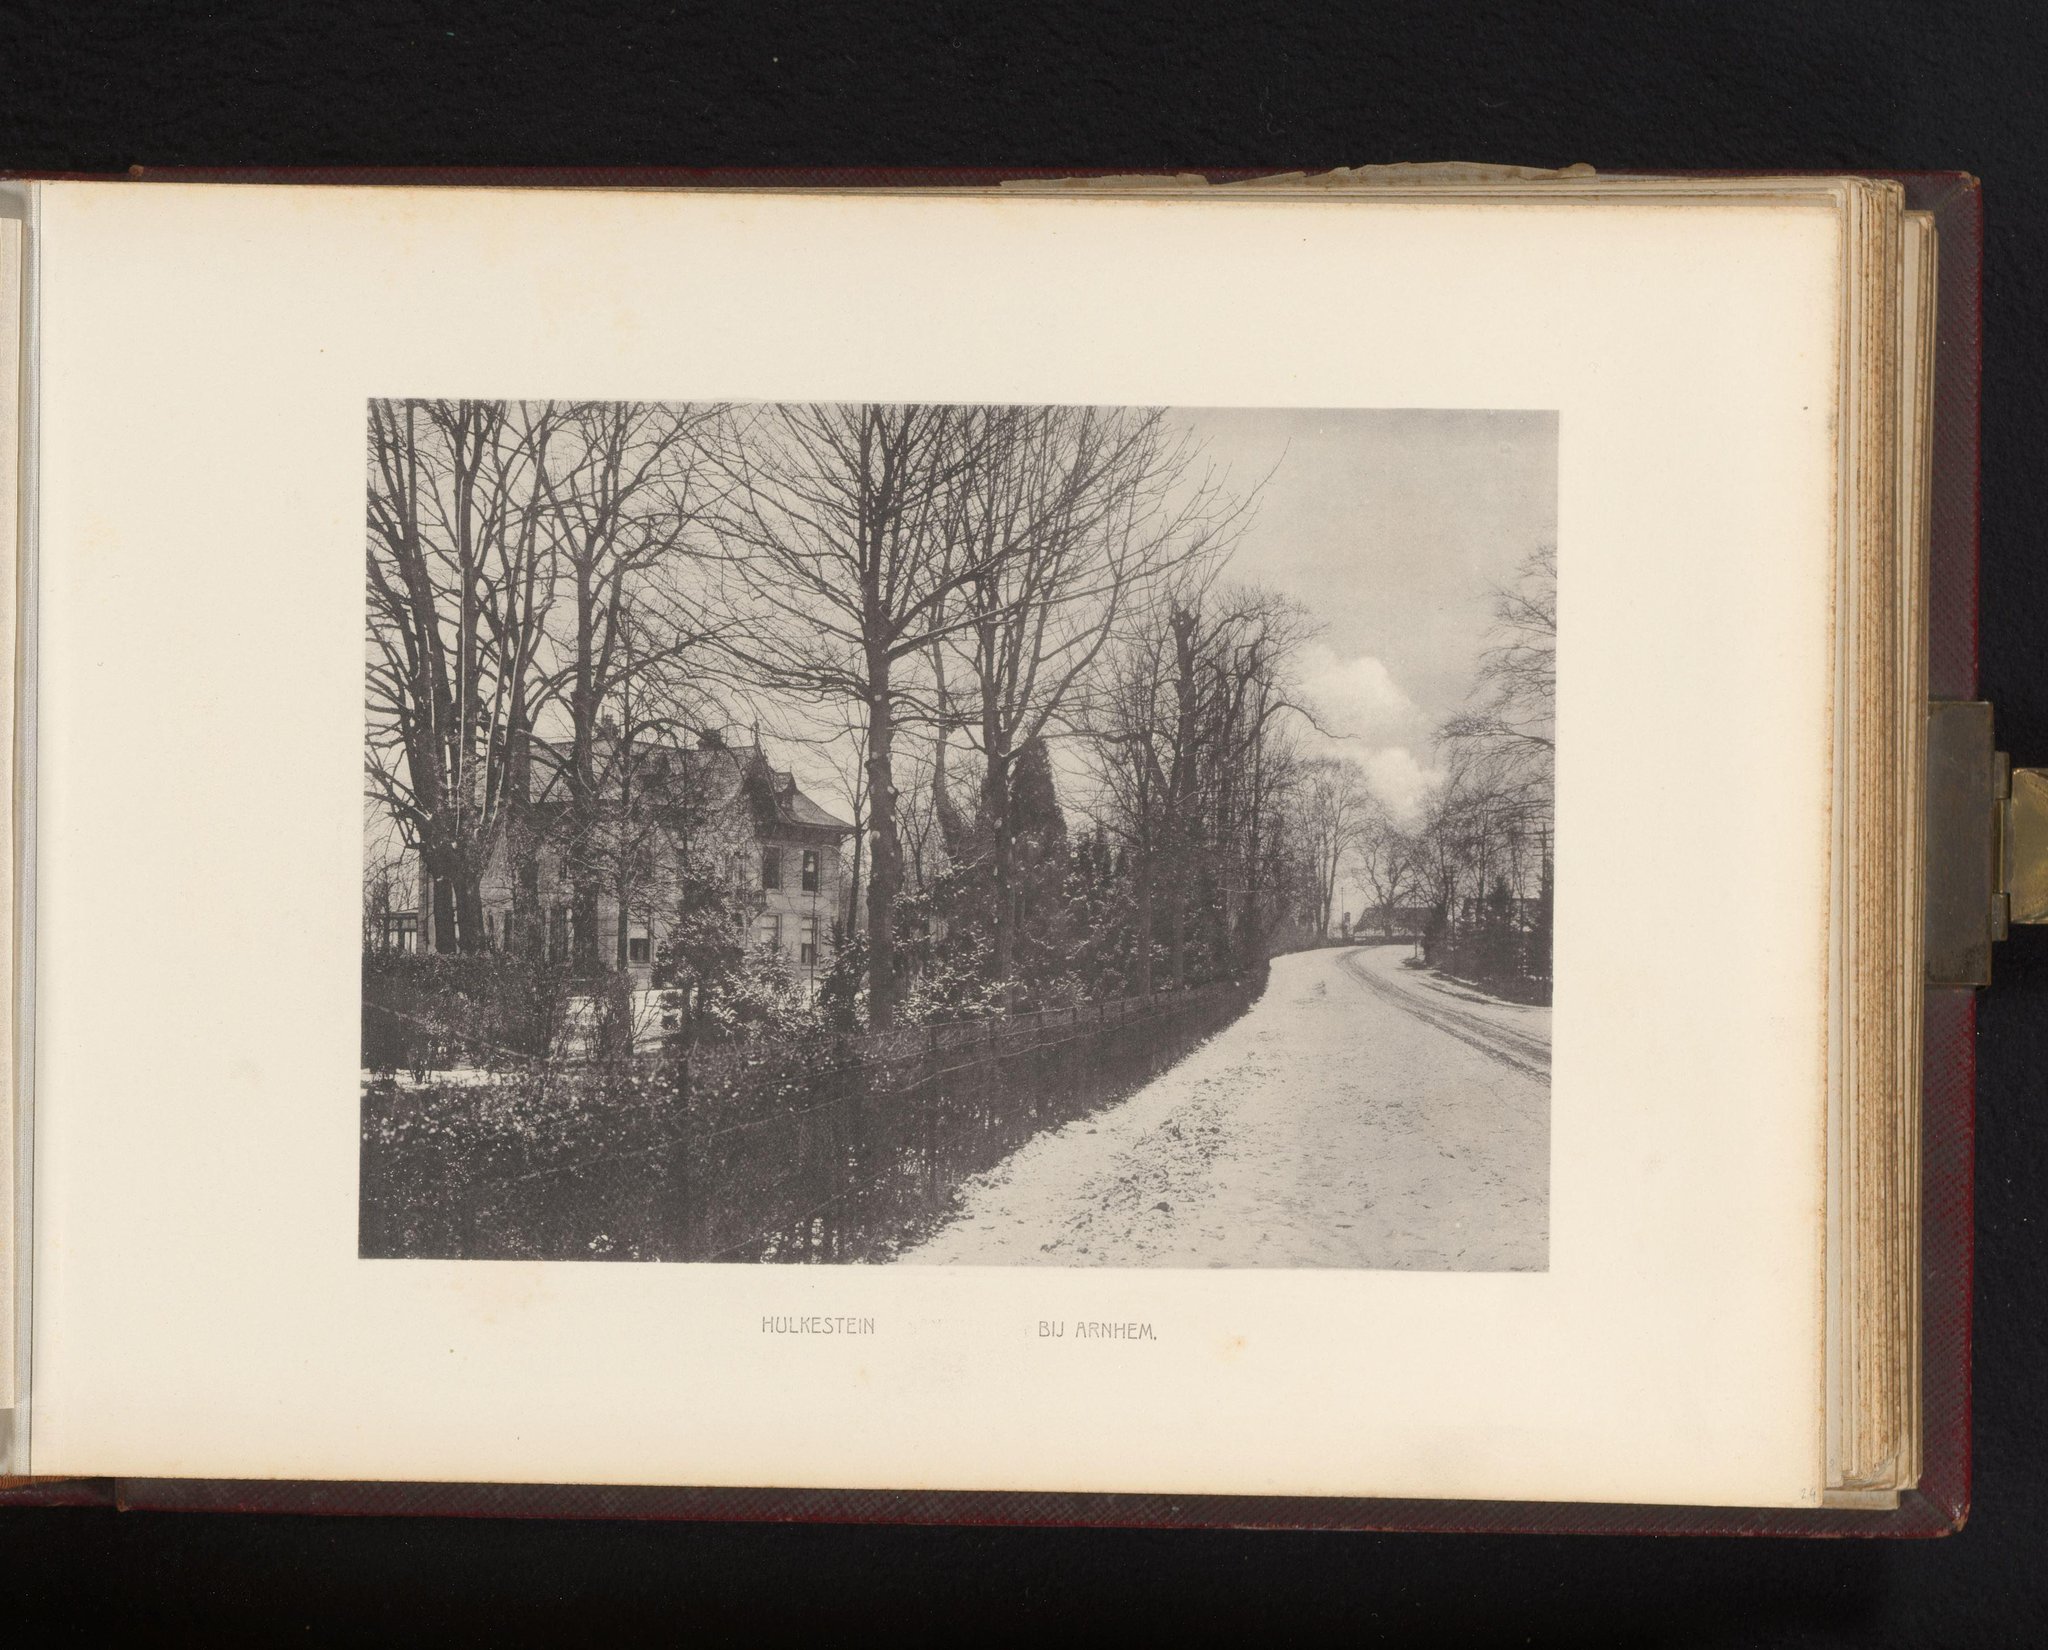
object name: album leaf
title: Hulkestein bij Arnhem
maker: Anonymous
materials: paper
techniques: photograph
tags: trees, country-house, arnhem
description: Deze pagina maakt deel uit van een album.